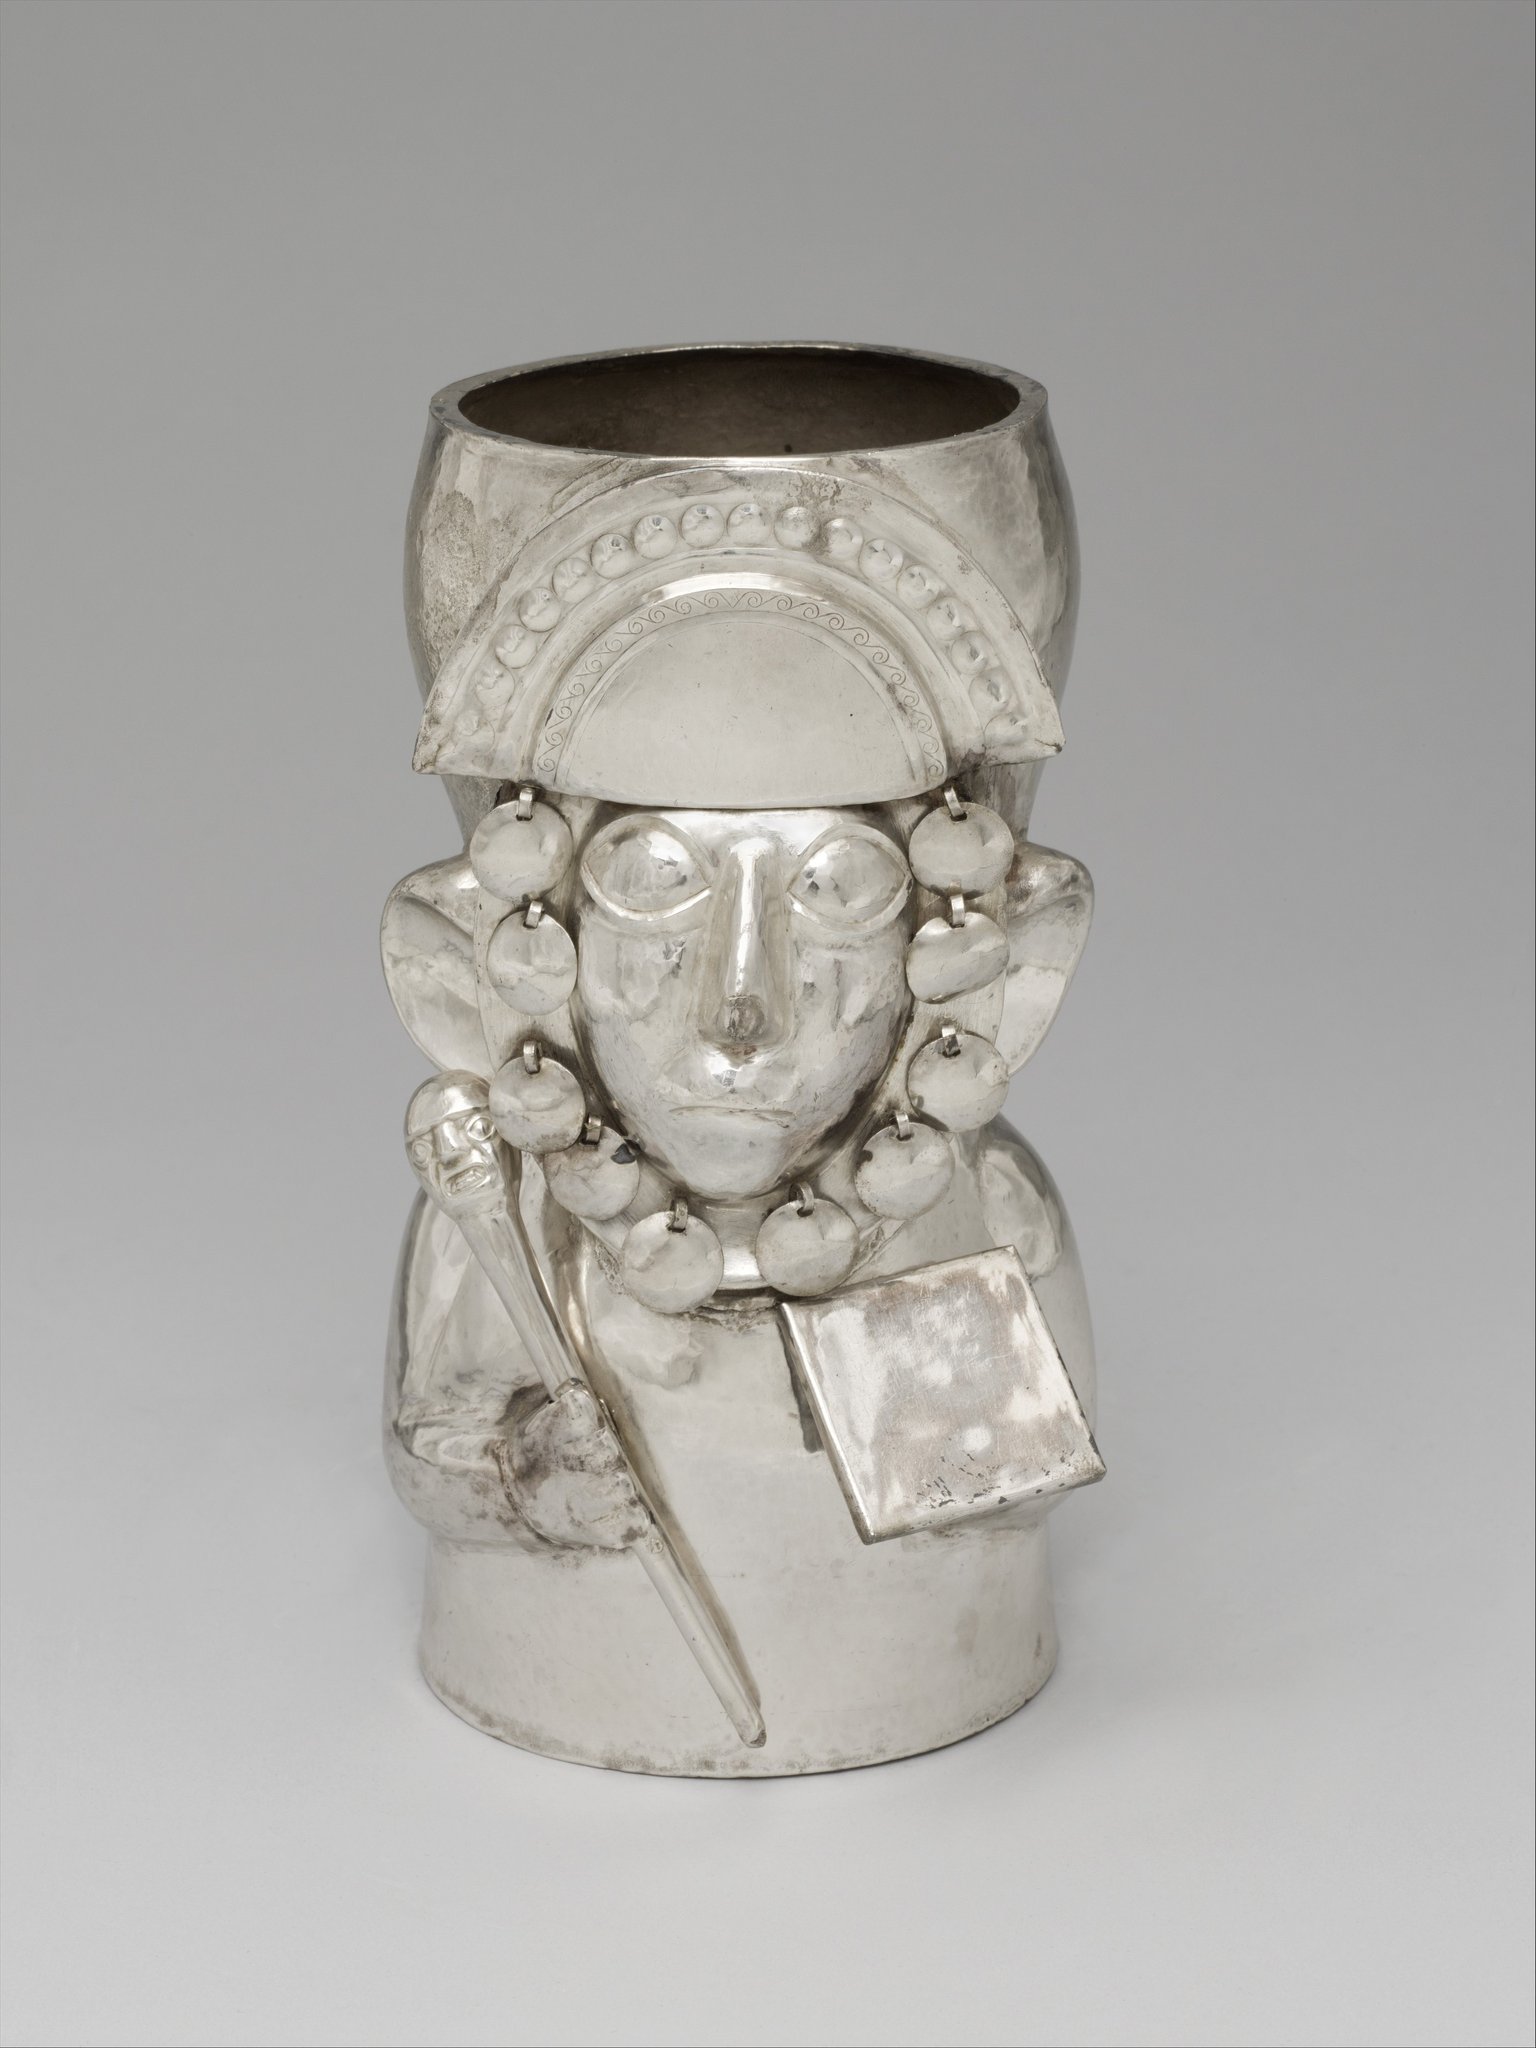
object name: vessel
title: Warrior vessel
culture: chimú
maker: chimú artist(s)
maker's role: artist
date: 1301-1500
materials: silver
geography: peru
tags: human figures